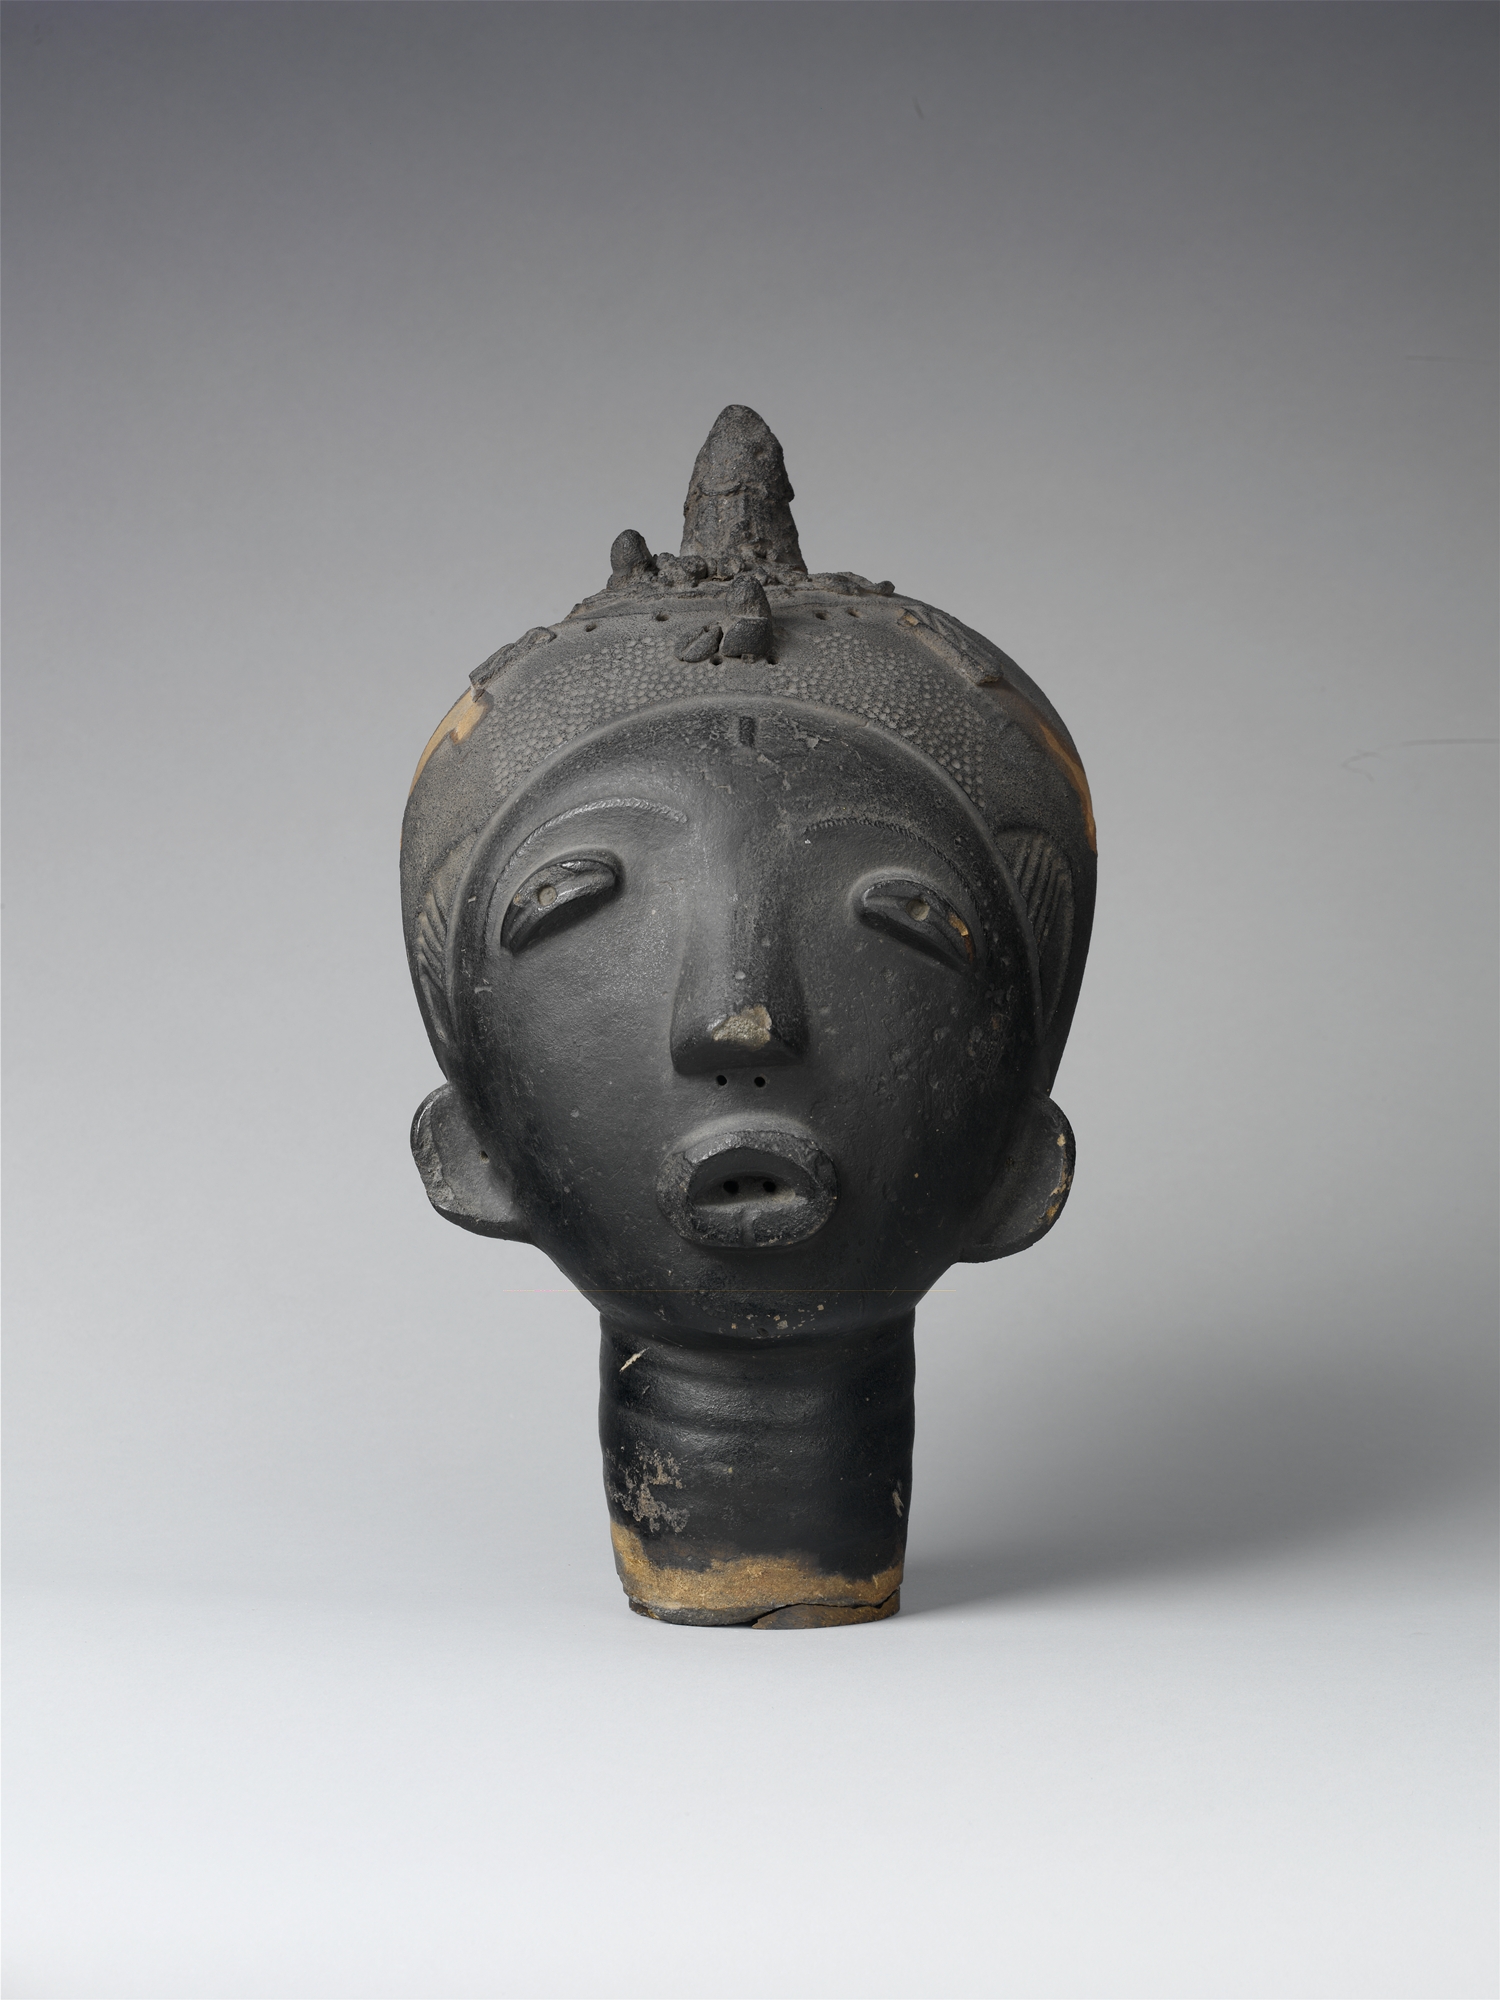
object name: head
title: Female ntiri (memorial head)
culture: akan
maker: akan artist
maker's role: artist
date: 1601-1700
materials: patina, terracotta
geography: ghana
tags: heads